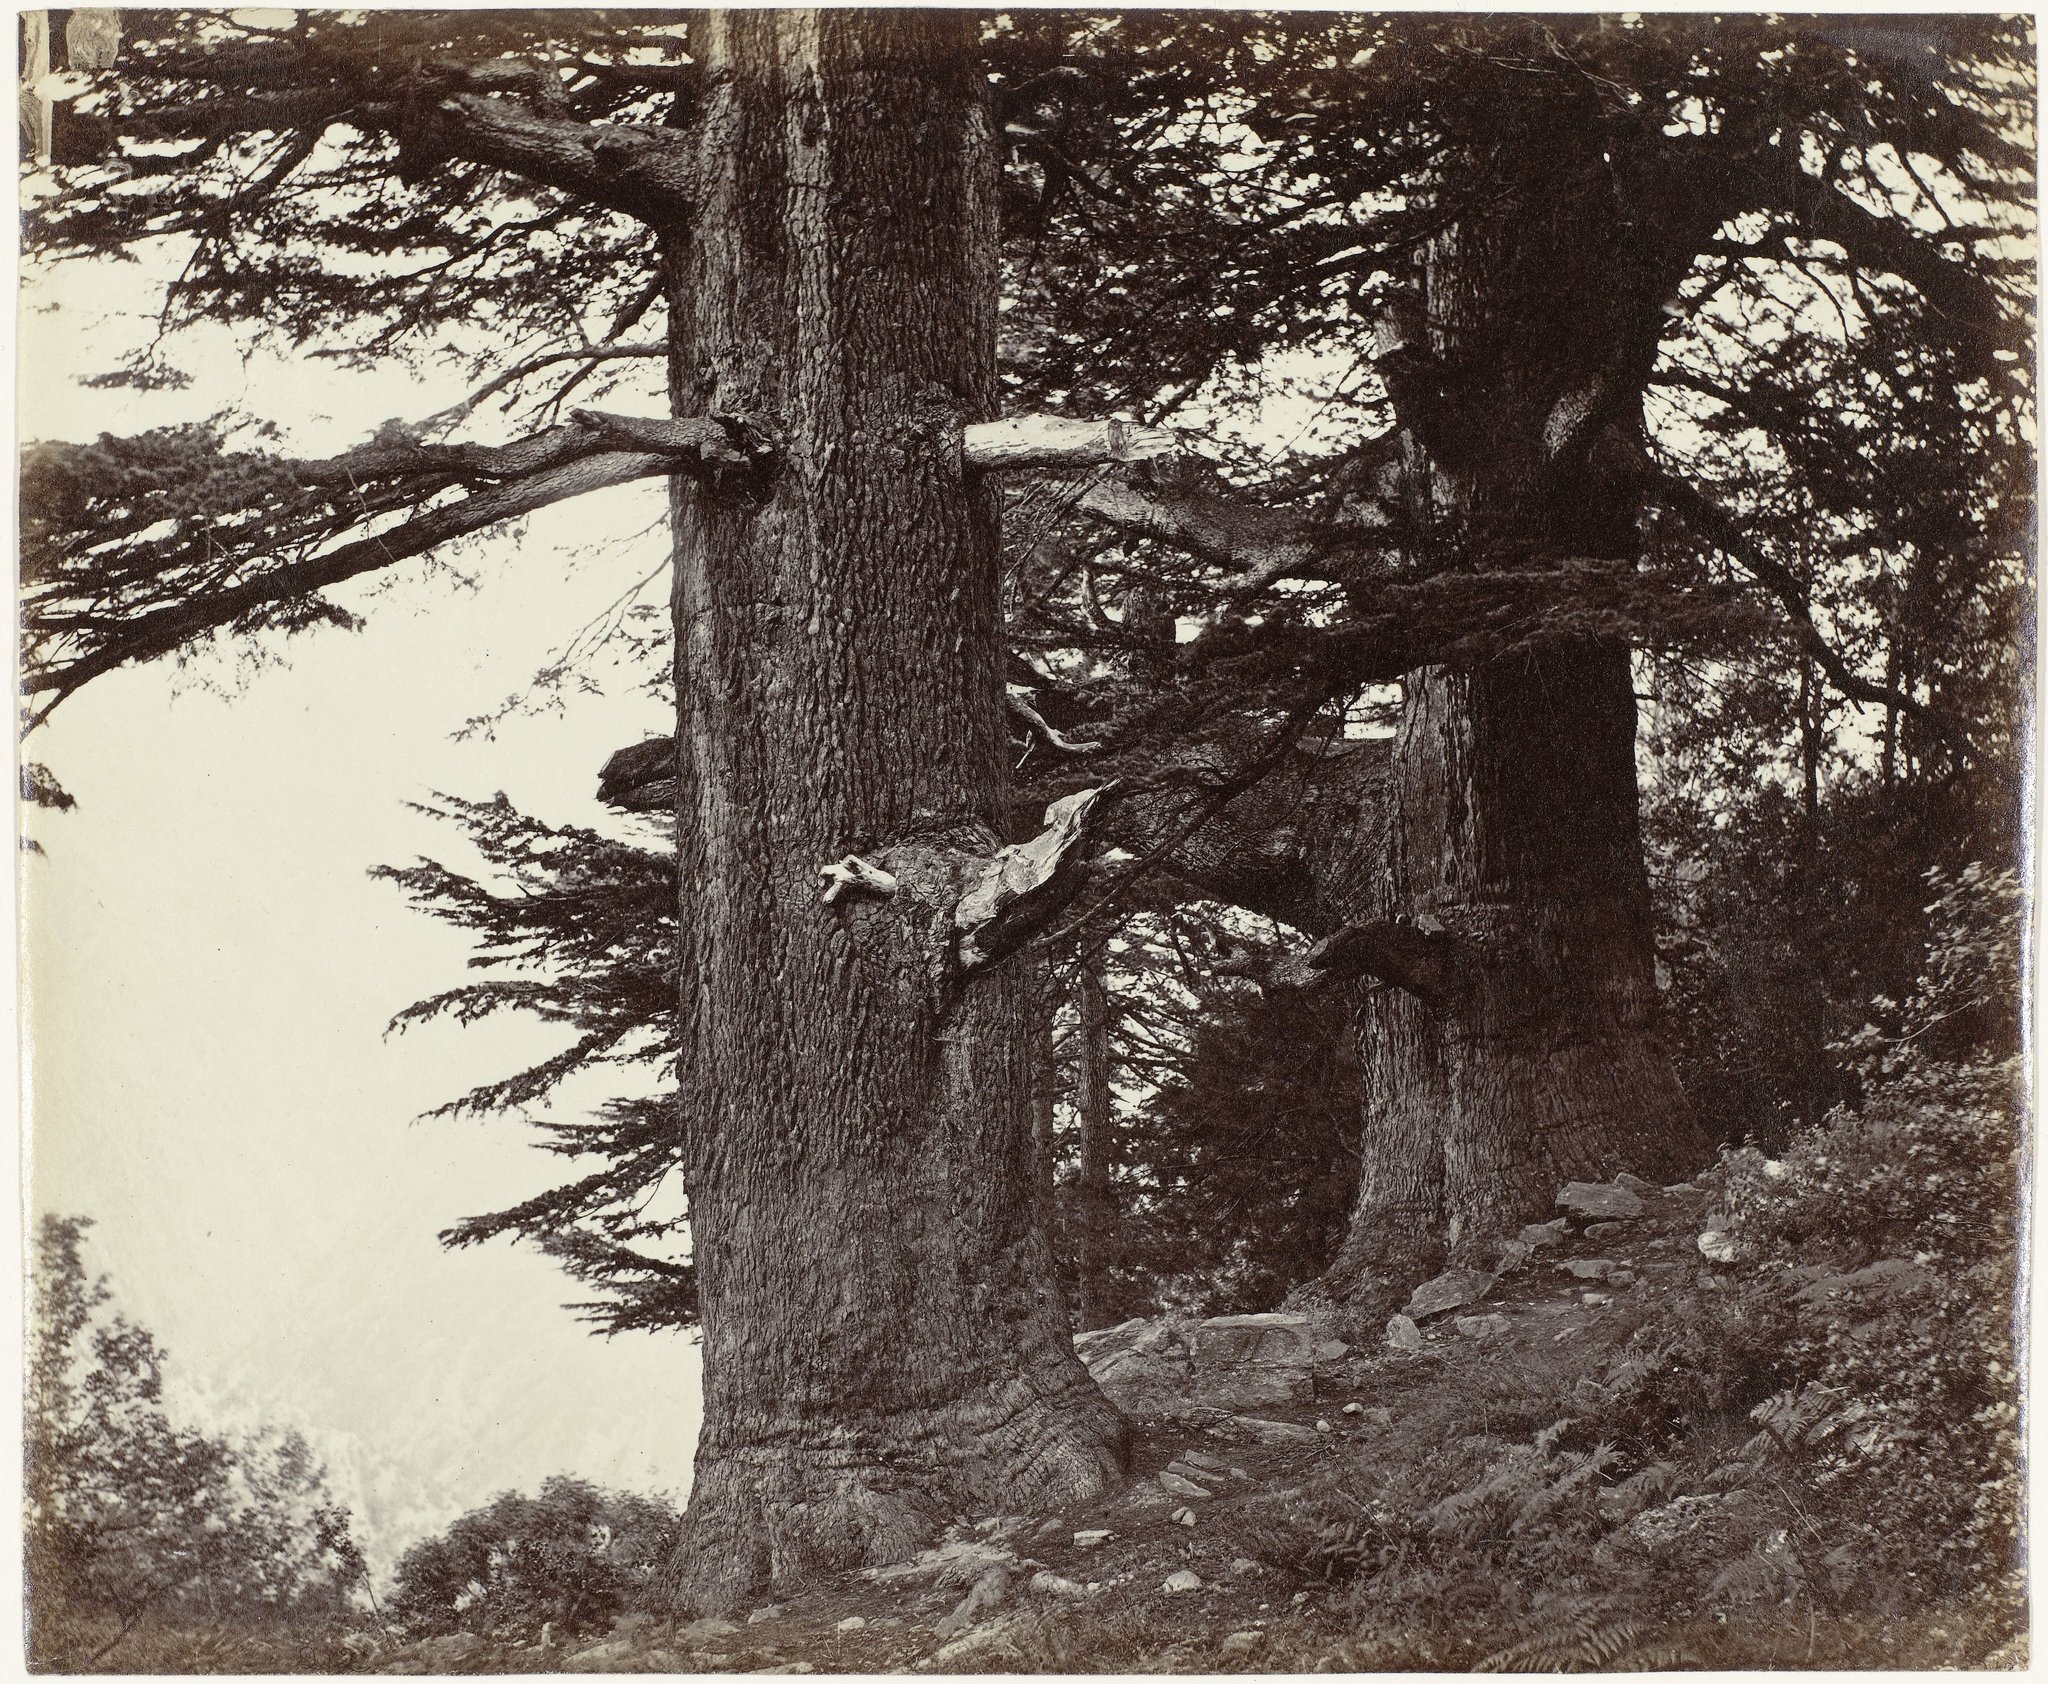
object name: photograph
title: Two cedar trees, Himachal Pradesh, India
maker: samuel bourne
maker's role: fotograaf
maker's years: 1834-1912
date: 1863-1864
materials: cardboard, paper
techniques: albumen print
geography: himachal pradesh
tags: trees: cedar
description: Deze foto moet Bourne hebben gemaakt in de deelstaat Himachal Pradesh, waarschijnlijk op zijn reis door de vallei van Sutlej in 1863.